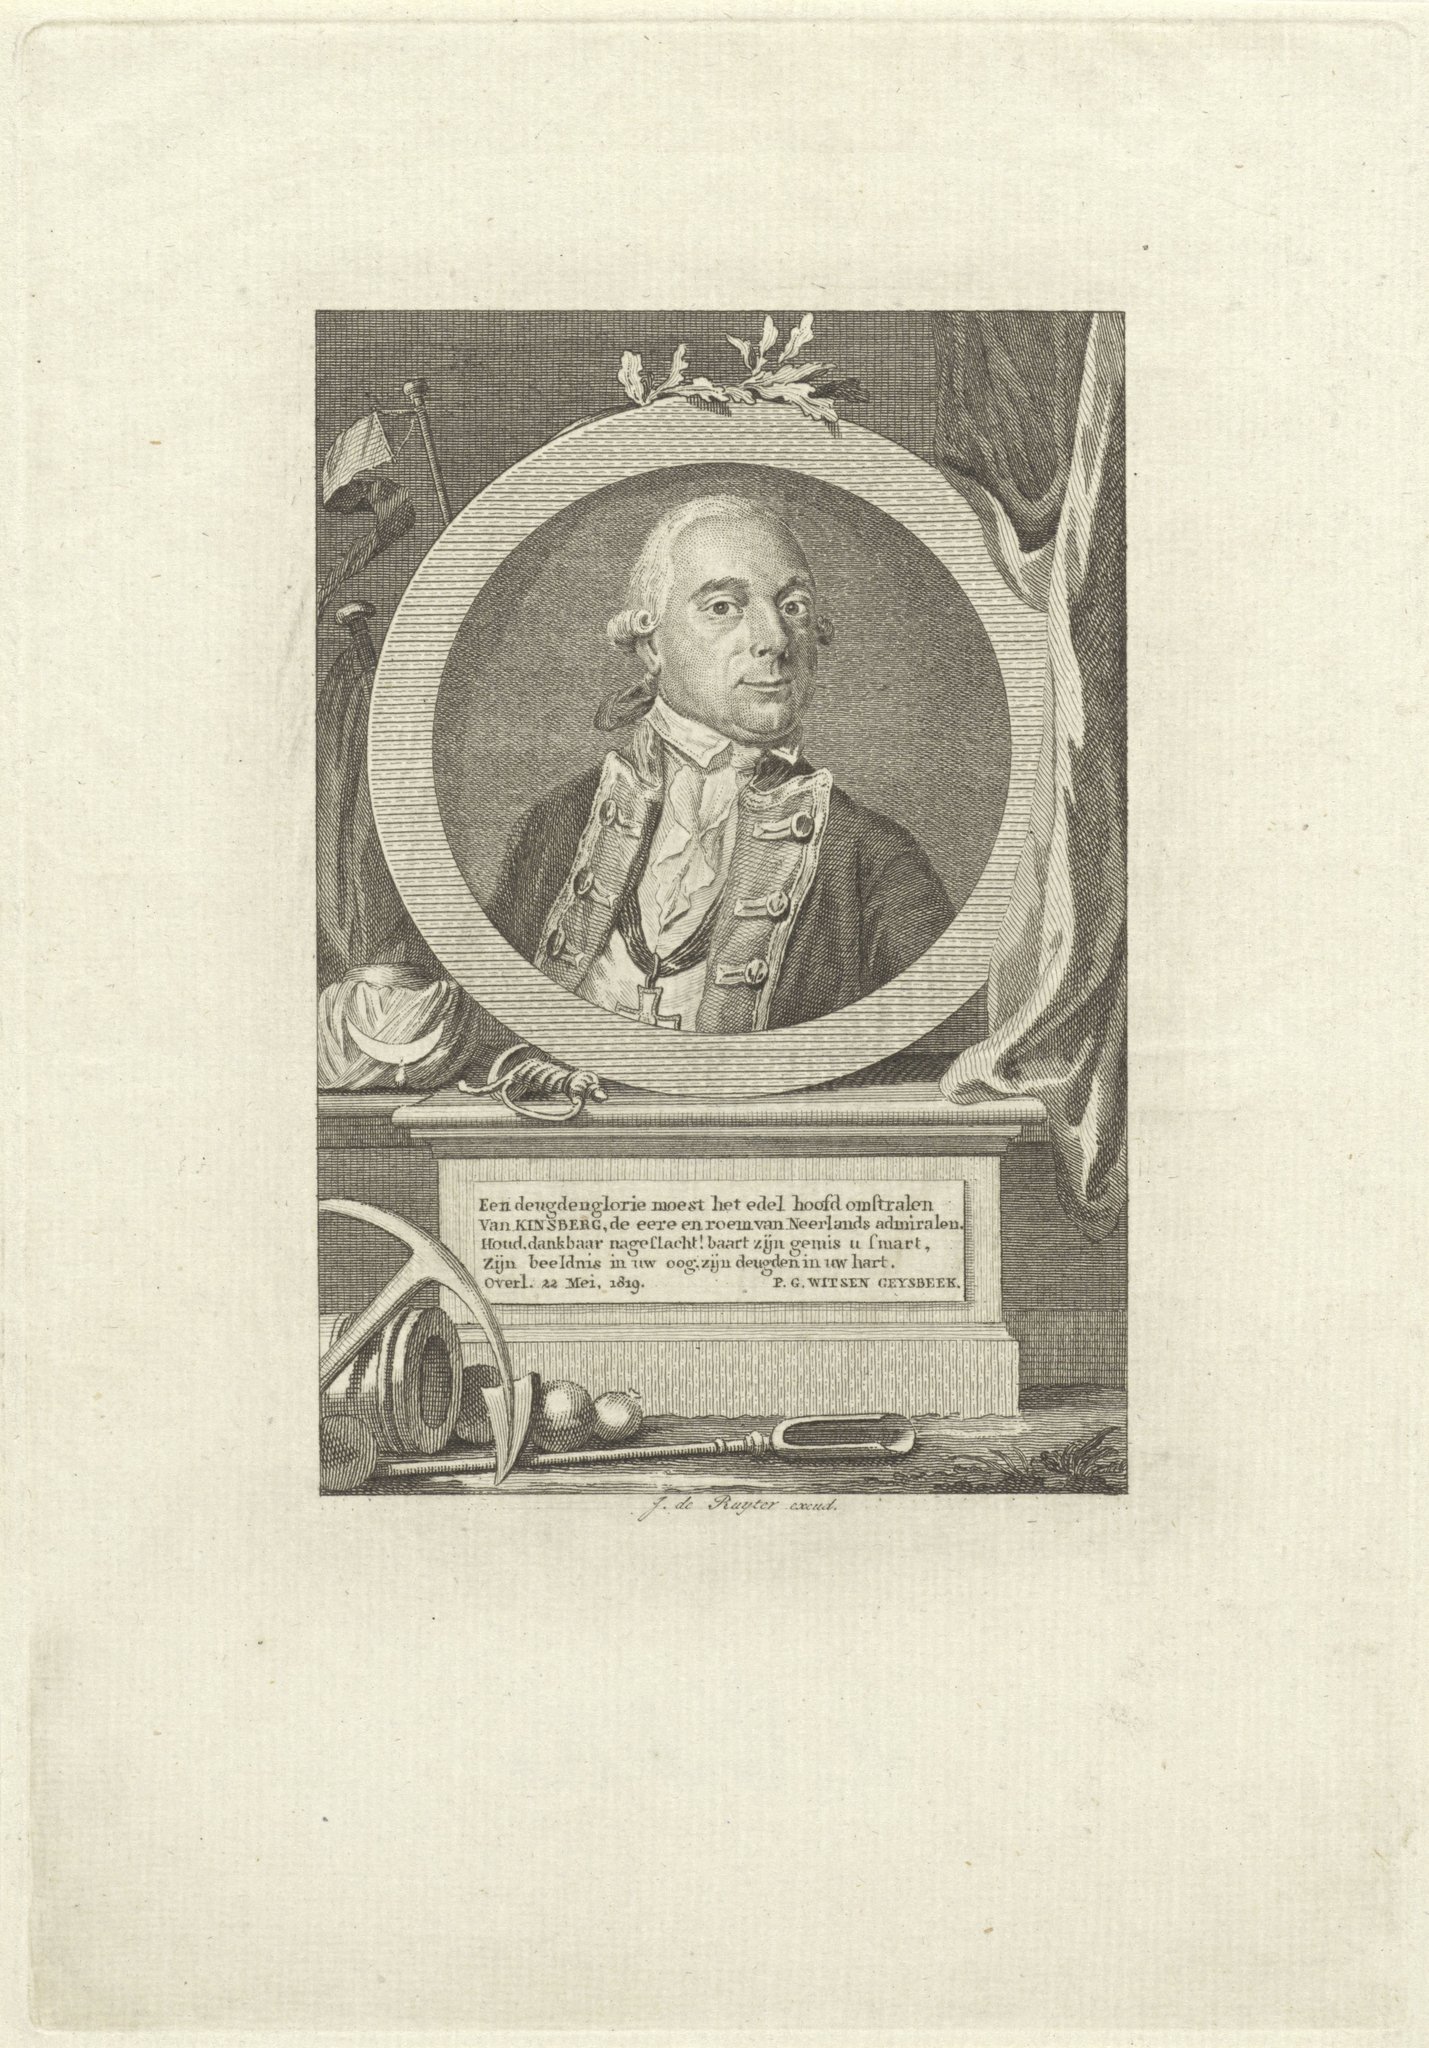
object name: print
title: Portret van de admiraal Jan Hendrik van Kinsbergen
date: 1819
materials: paper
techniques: etching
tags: jonkheer jan hendrik van kinsbergen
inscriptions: collector's mark: Lugt 2228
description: Portret van Jan Hendrik van Kinsbergen, vice-admiraal en buitengewoon maarschalk der Hollandse zeemacht.